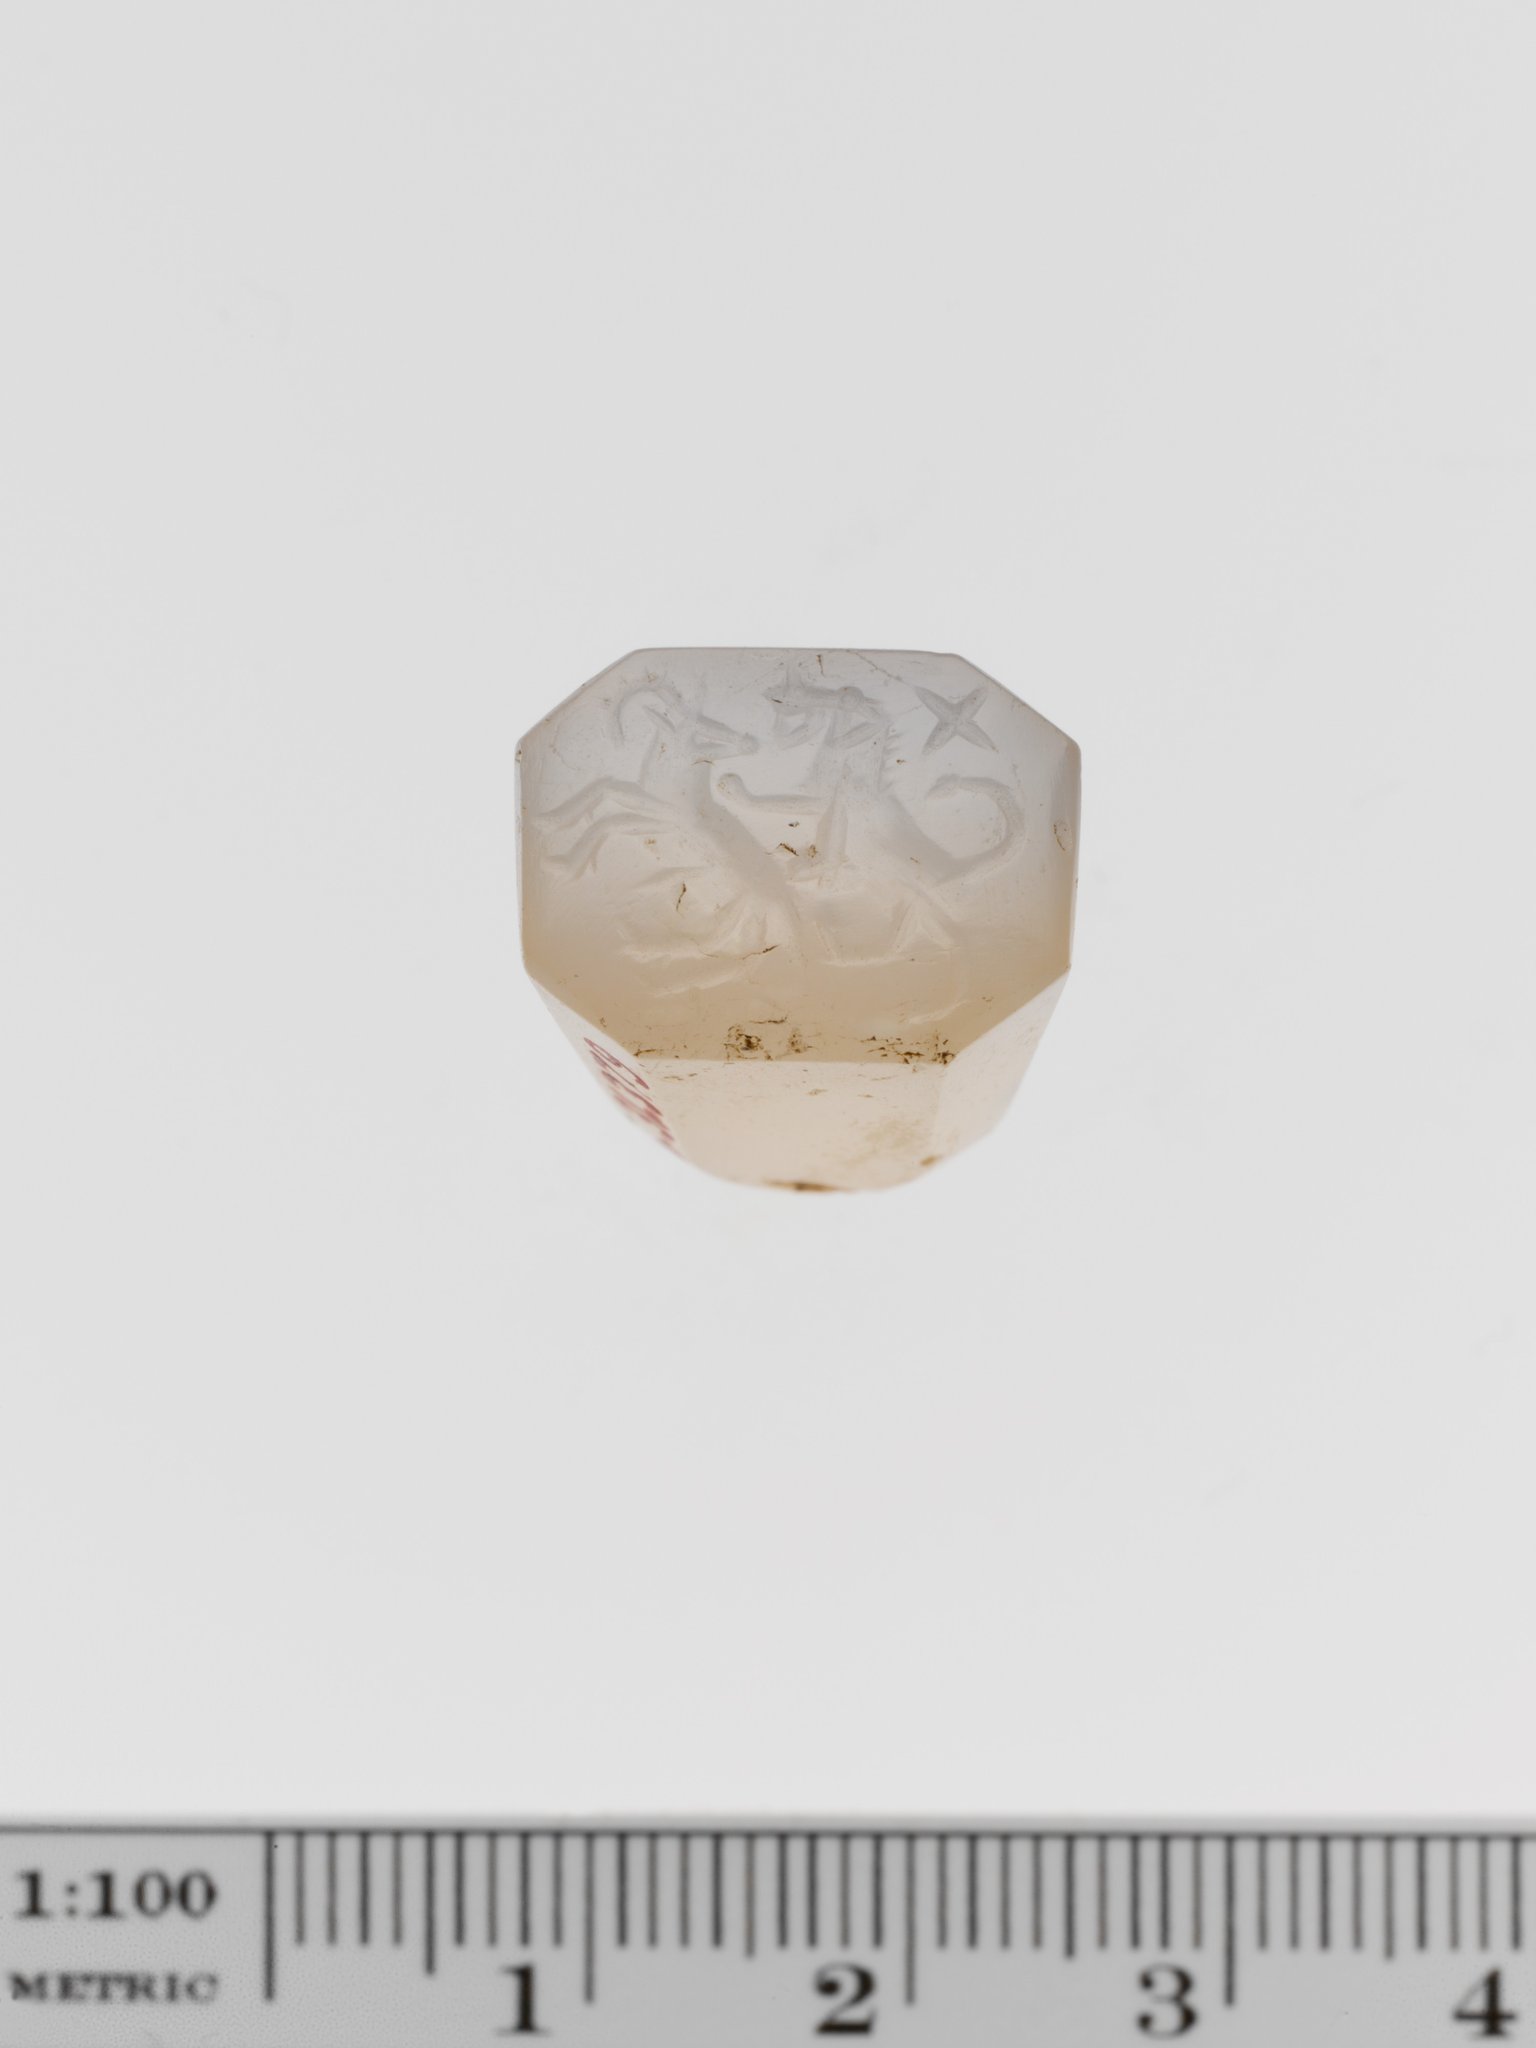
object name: cone, eight sided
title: Chalcedony eight-sided cone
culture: greek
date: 600-501 BCE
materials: stone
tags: goats,lions